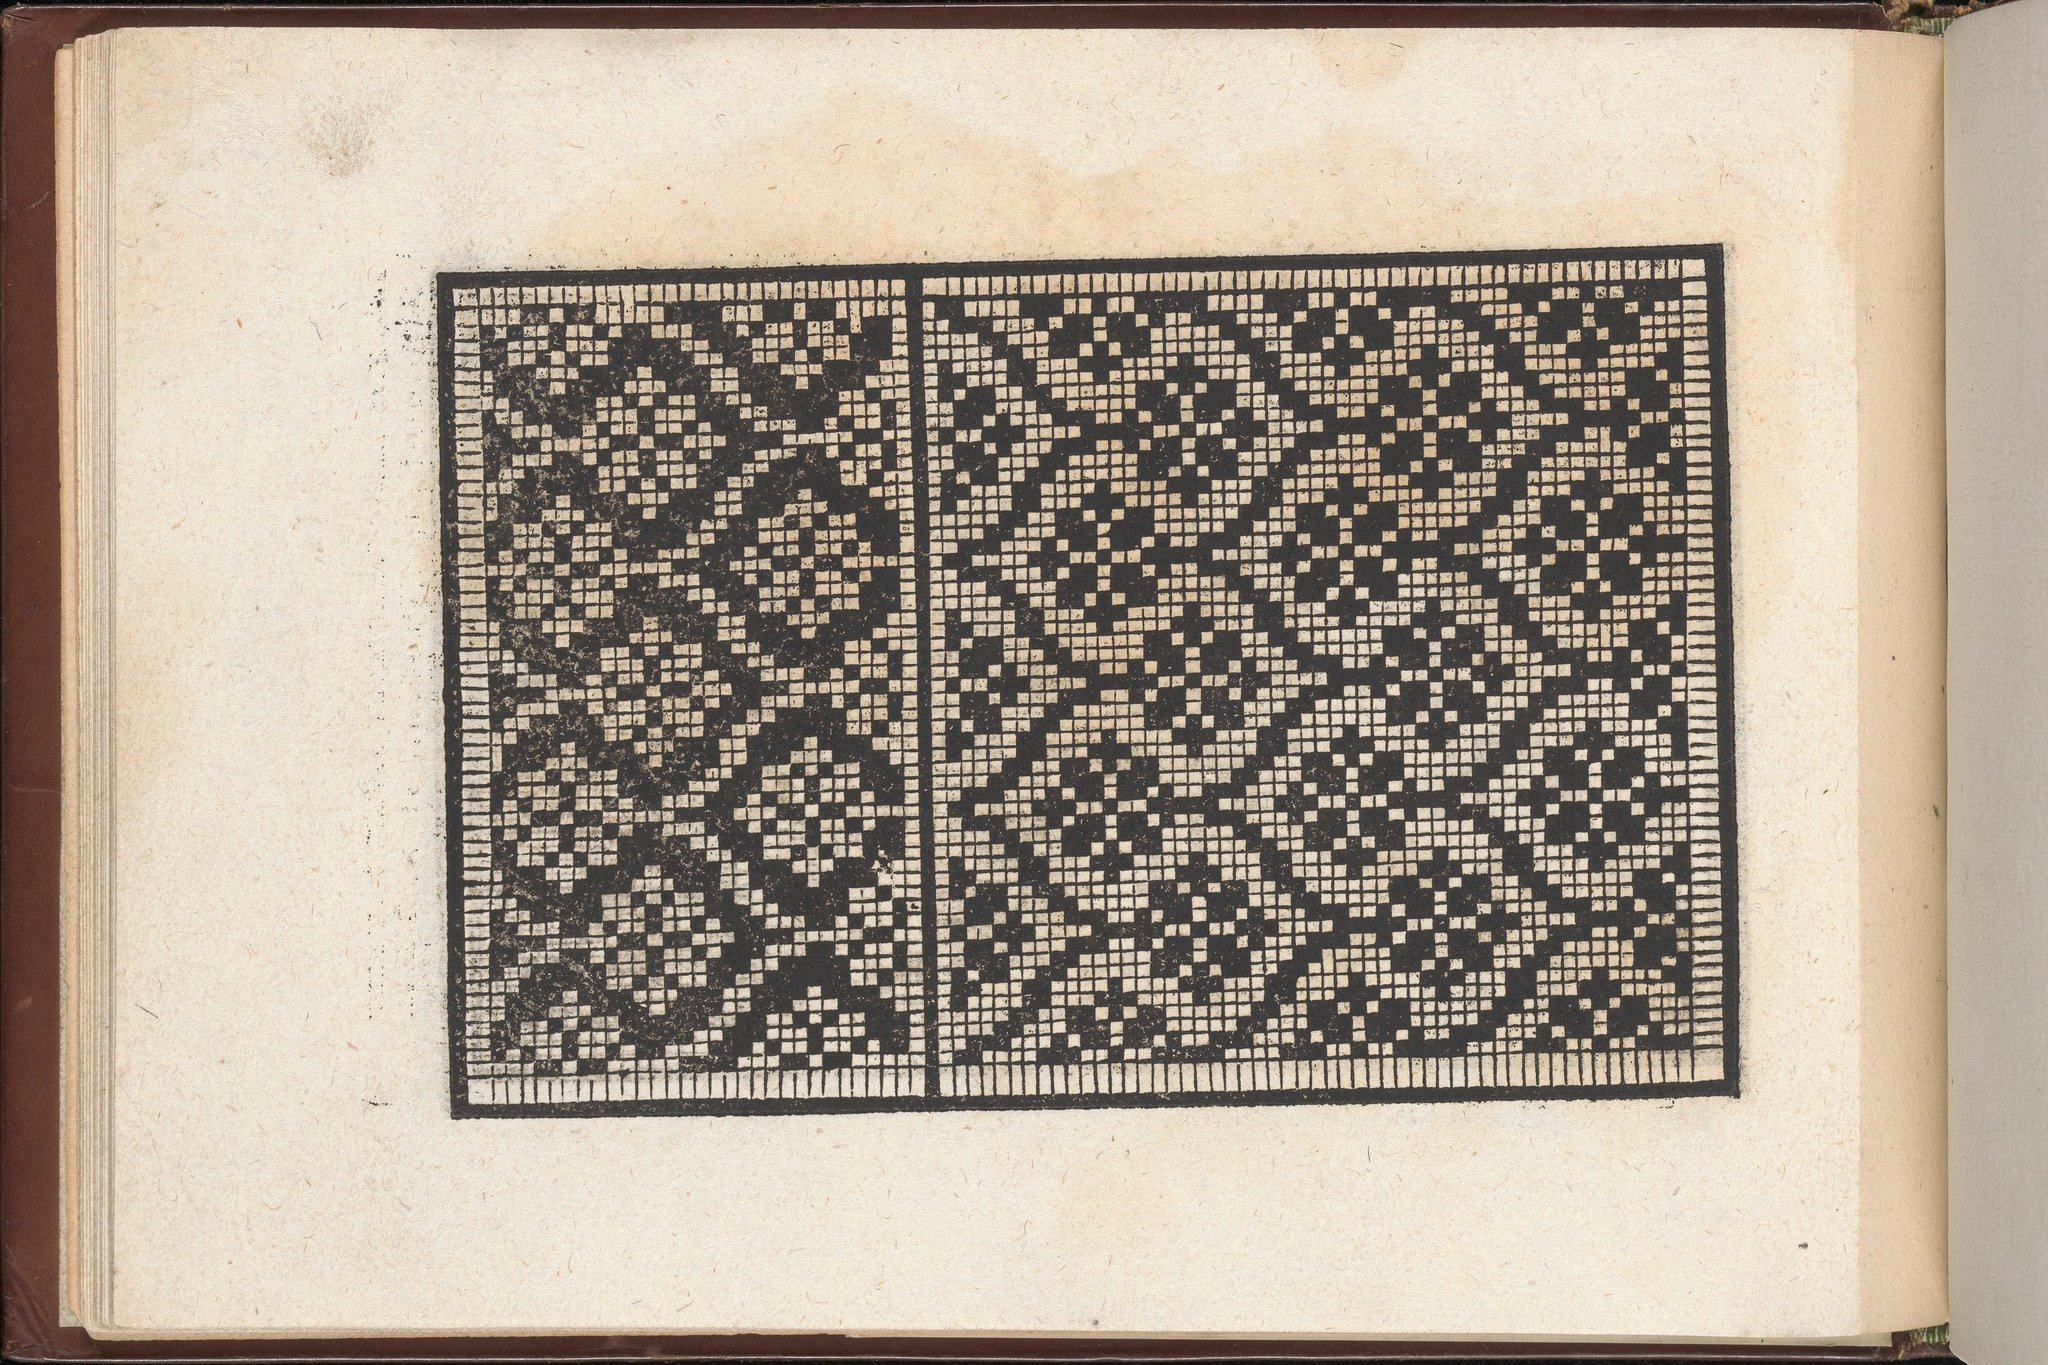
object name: book print ornament architecture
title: Page from Eyn Newe kunstlich moetdelboech alle kunst (Page 16v)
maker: peter quentel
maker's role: publisher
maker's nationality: german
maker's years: 1500-1550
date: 1532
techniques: woodcut